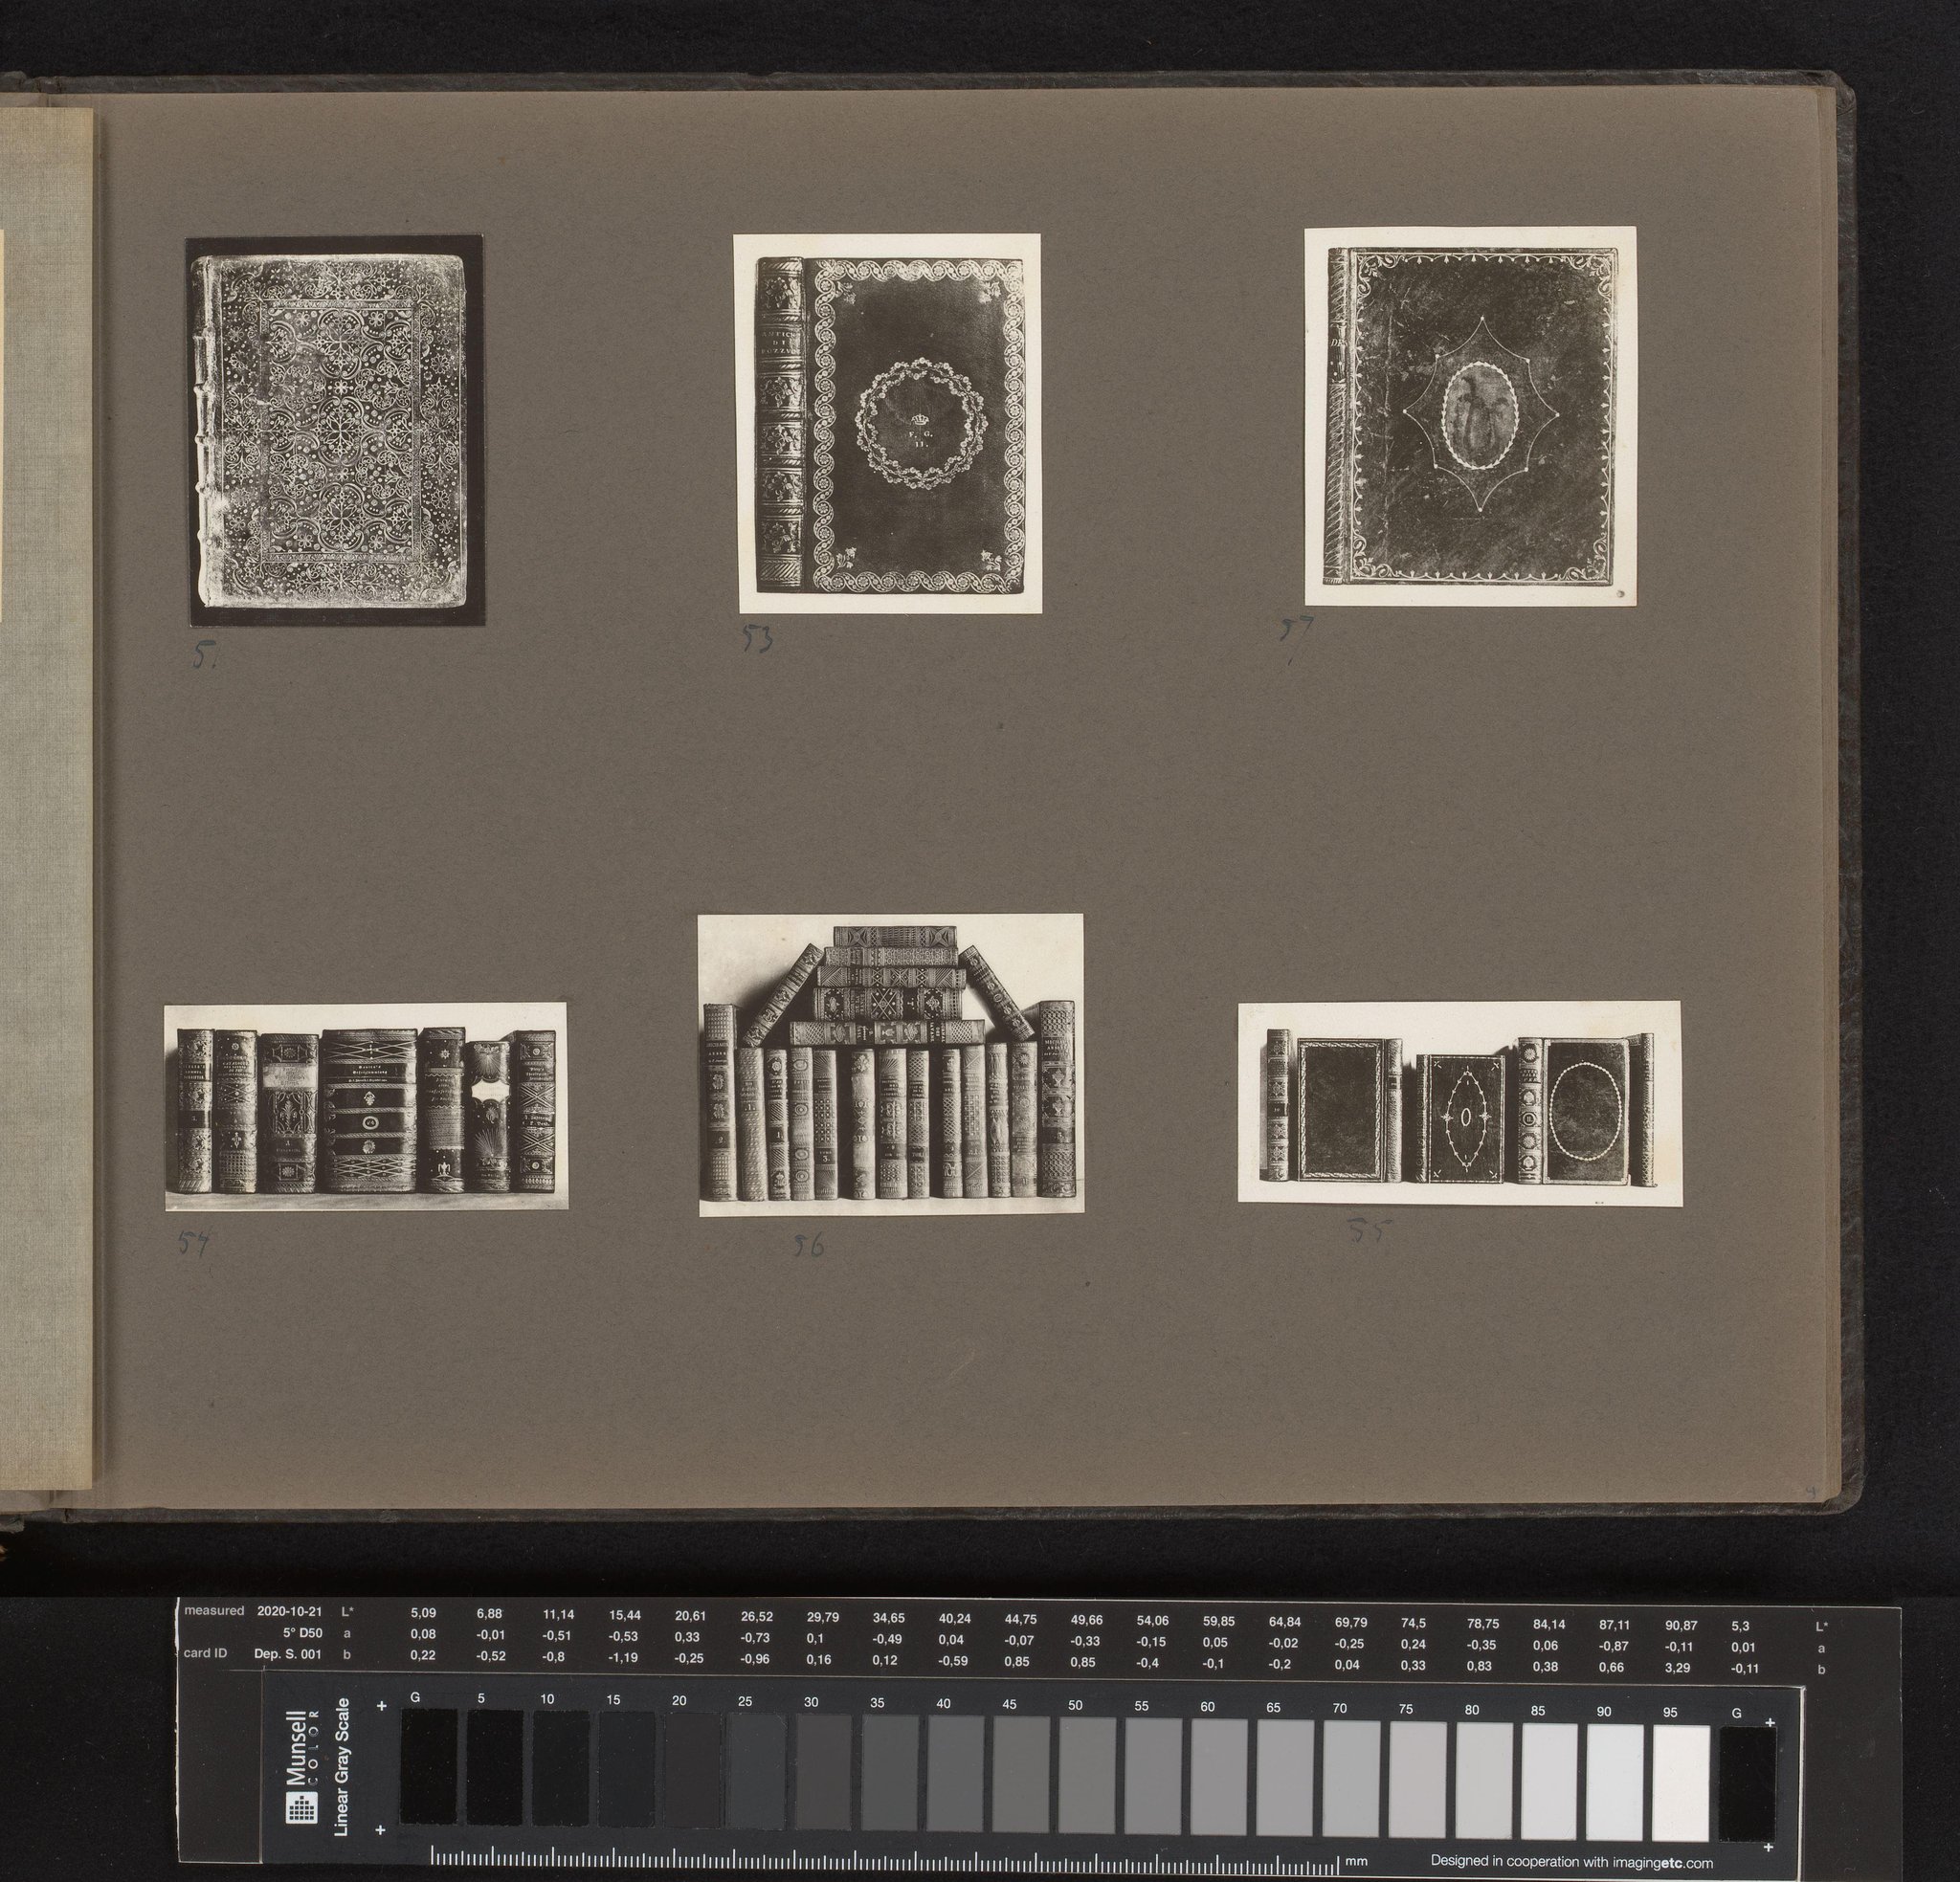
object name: album leaf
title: Boekbanden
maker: Anonymous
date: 1920-1940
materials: paper, photographic support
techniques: gelatin silver print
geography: netherlands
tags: book-cover, binding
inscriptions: number: ‘51 - 53 - 57/ 54 - 56 - 55’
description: Drie foto's van een boekband en drie foto's van de ruggen en banden van respectievelijk zeven, twintig en vijf boeken. Deze foto's maken deel uit van een album.